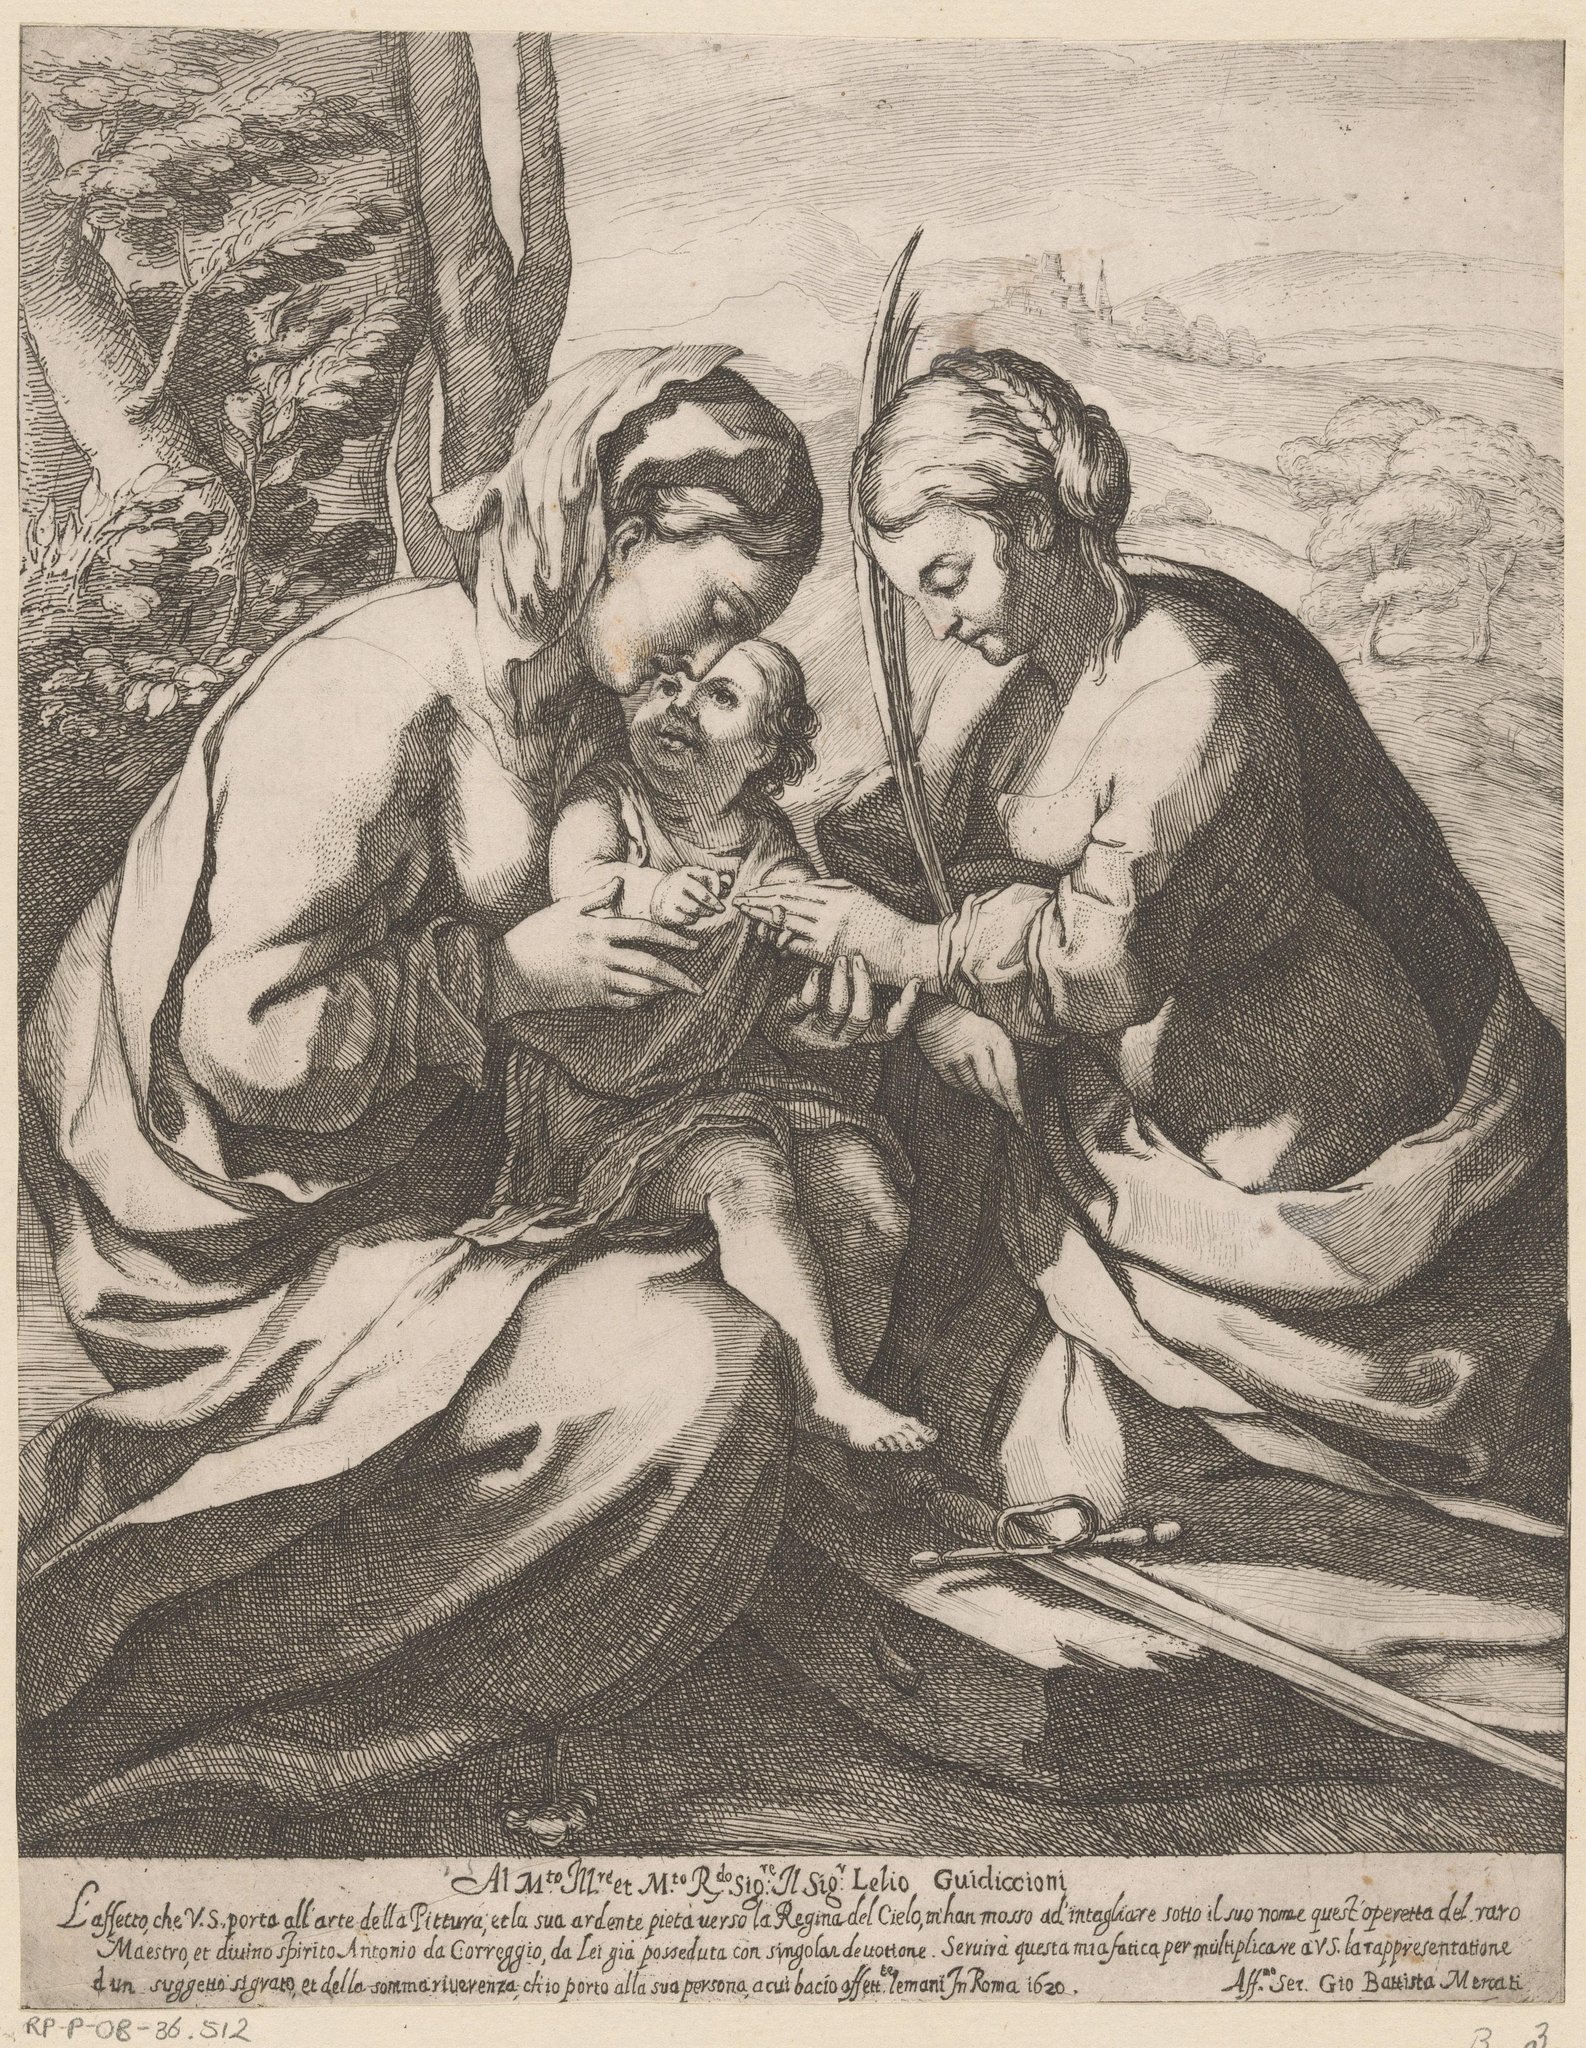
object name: print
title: Het mystieke huwelijk van de heilige Catharina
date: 1620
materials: paper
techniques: etching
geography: italy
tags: the virgin martyr catherine of alexandria; possible attributes: book, crown, emperor maxentius, palm-branch, ring, sword, wheel, mystic marriage, the mystic marriage of st. catherine of alexandria with the infant christ: the christ-child puts a ring on her finger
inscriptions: collector's mark: Lugt 240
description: Maria houdt het Christuskind op schoot. Het Christuskind schuift een ring om de vinger van de heilige Catharina van Alexandrië. Op de achtergrond een landschap. Opdracht in ondermarge.